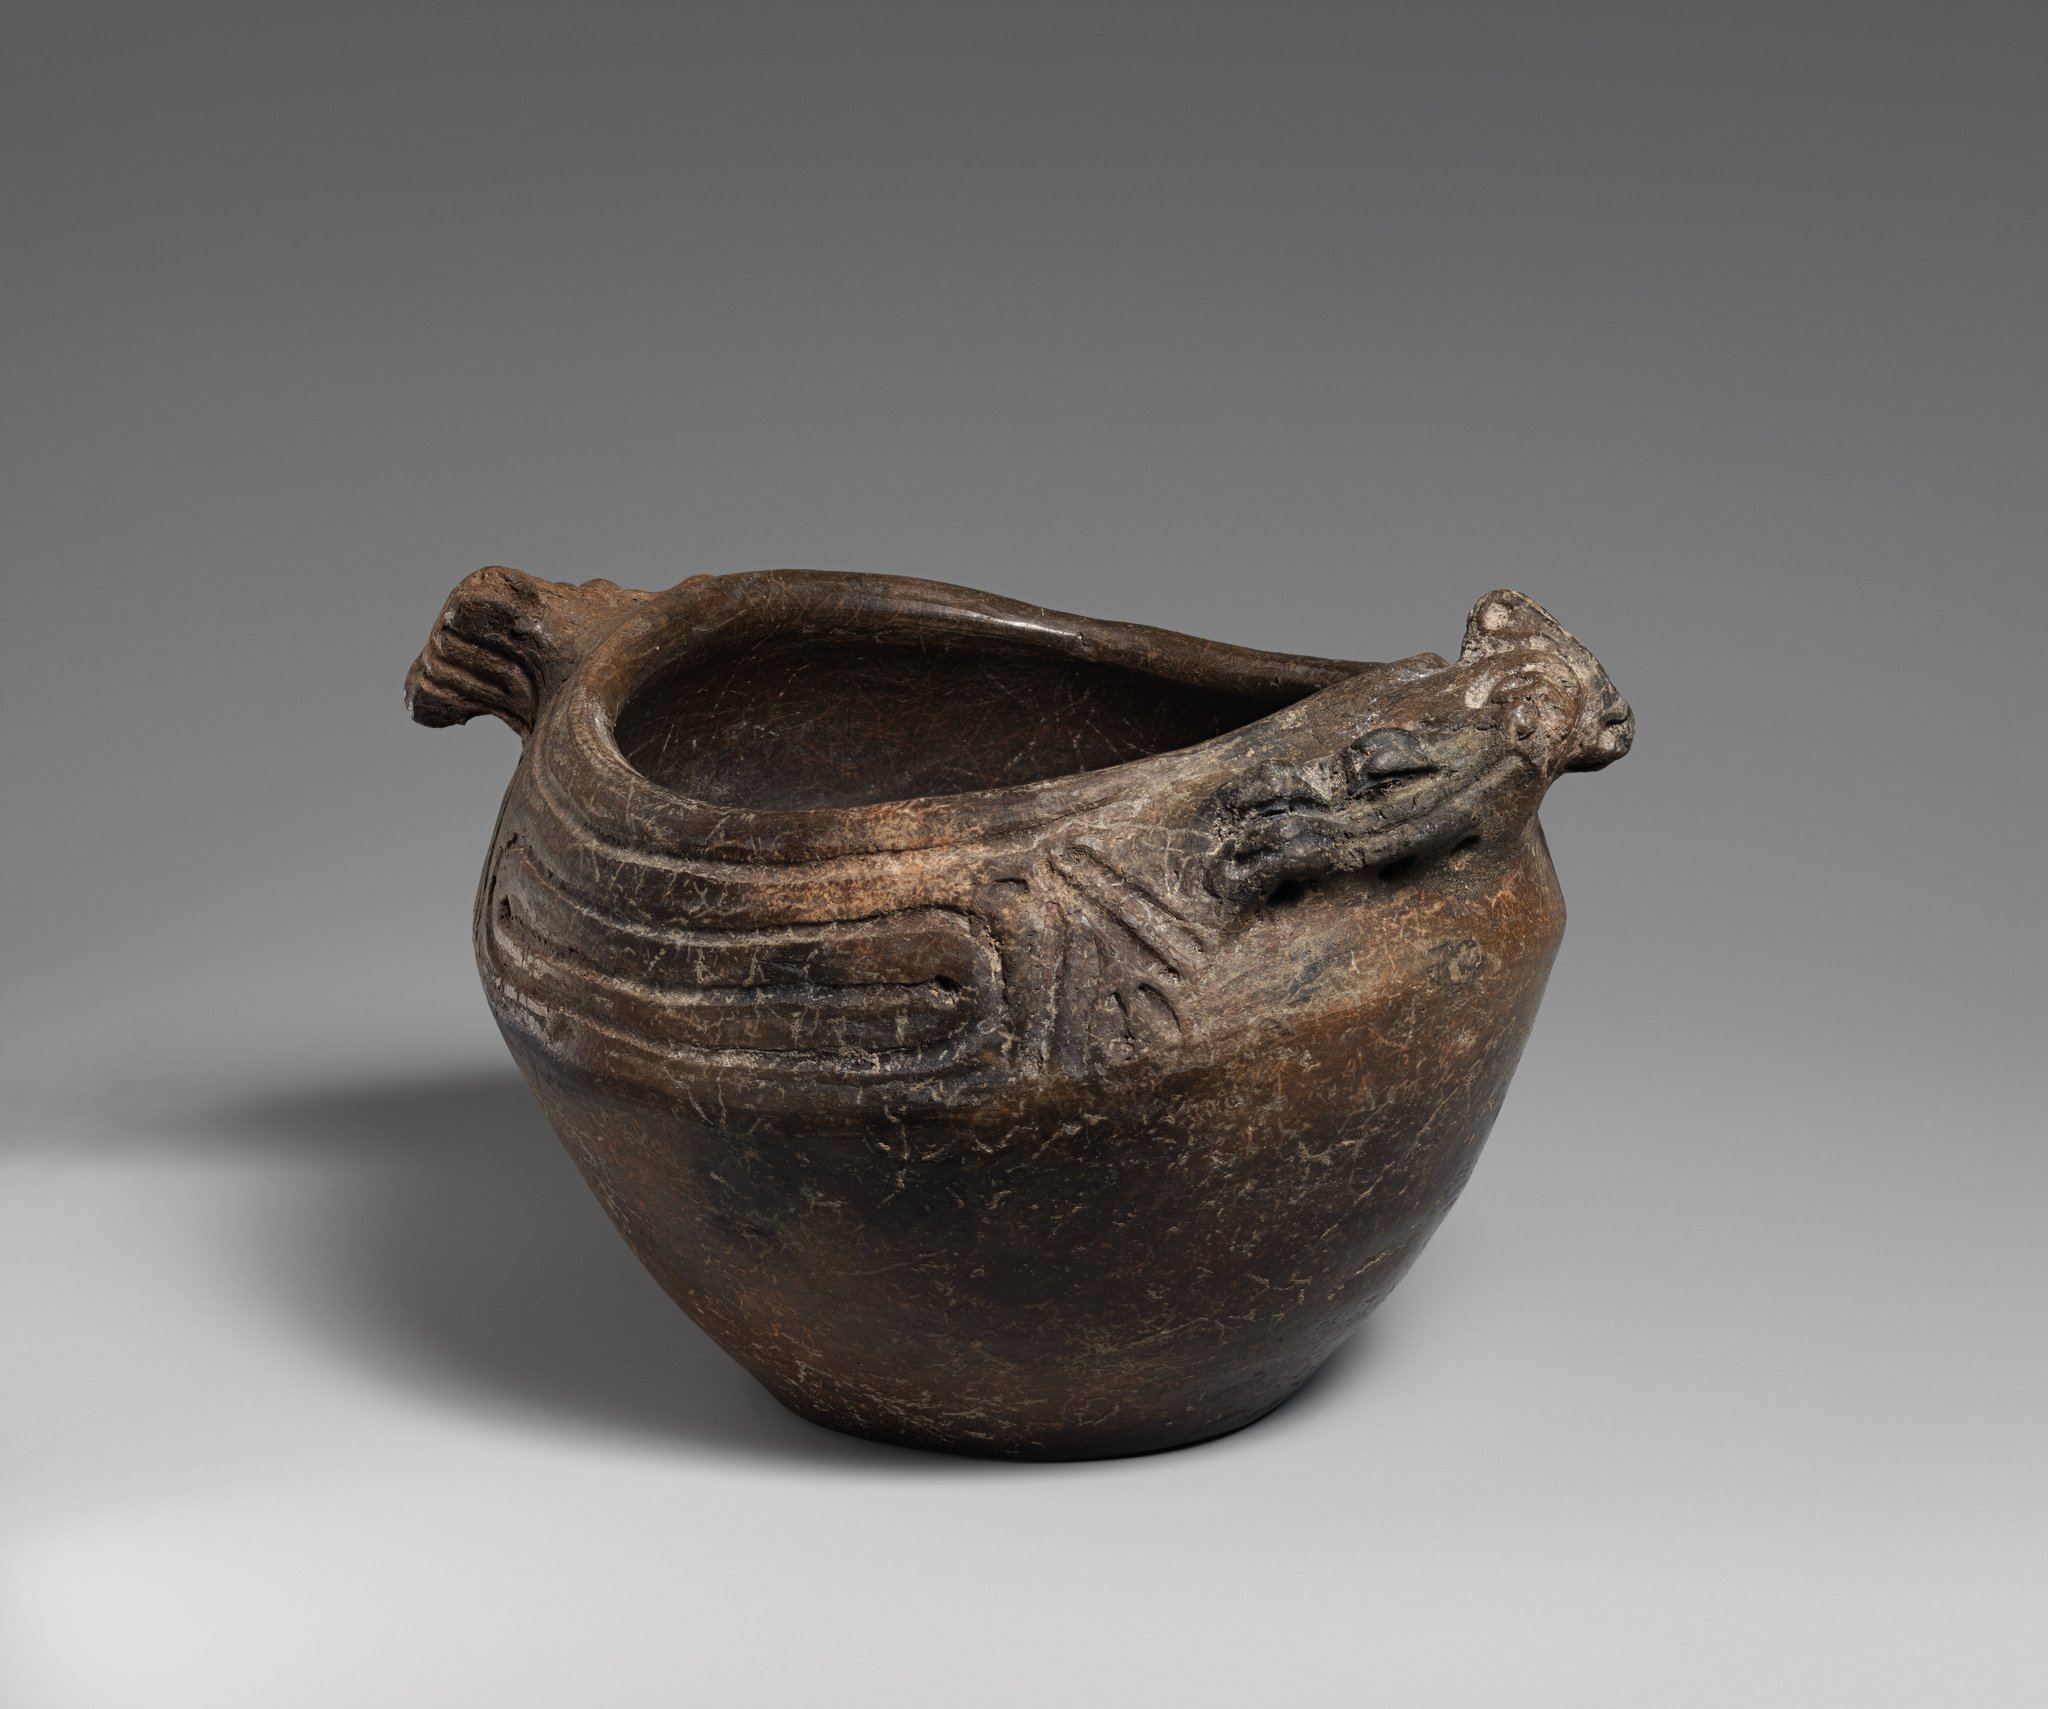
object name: bowl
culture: taíno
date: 1201-1500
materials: ceramic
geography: dominican republic